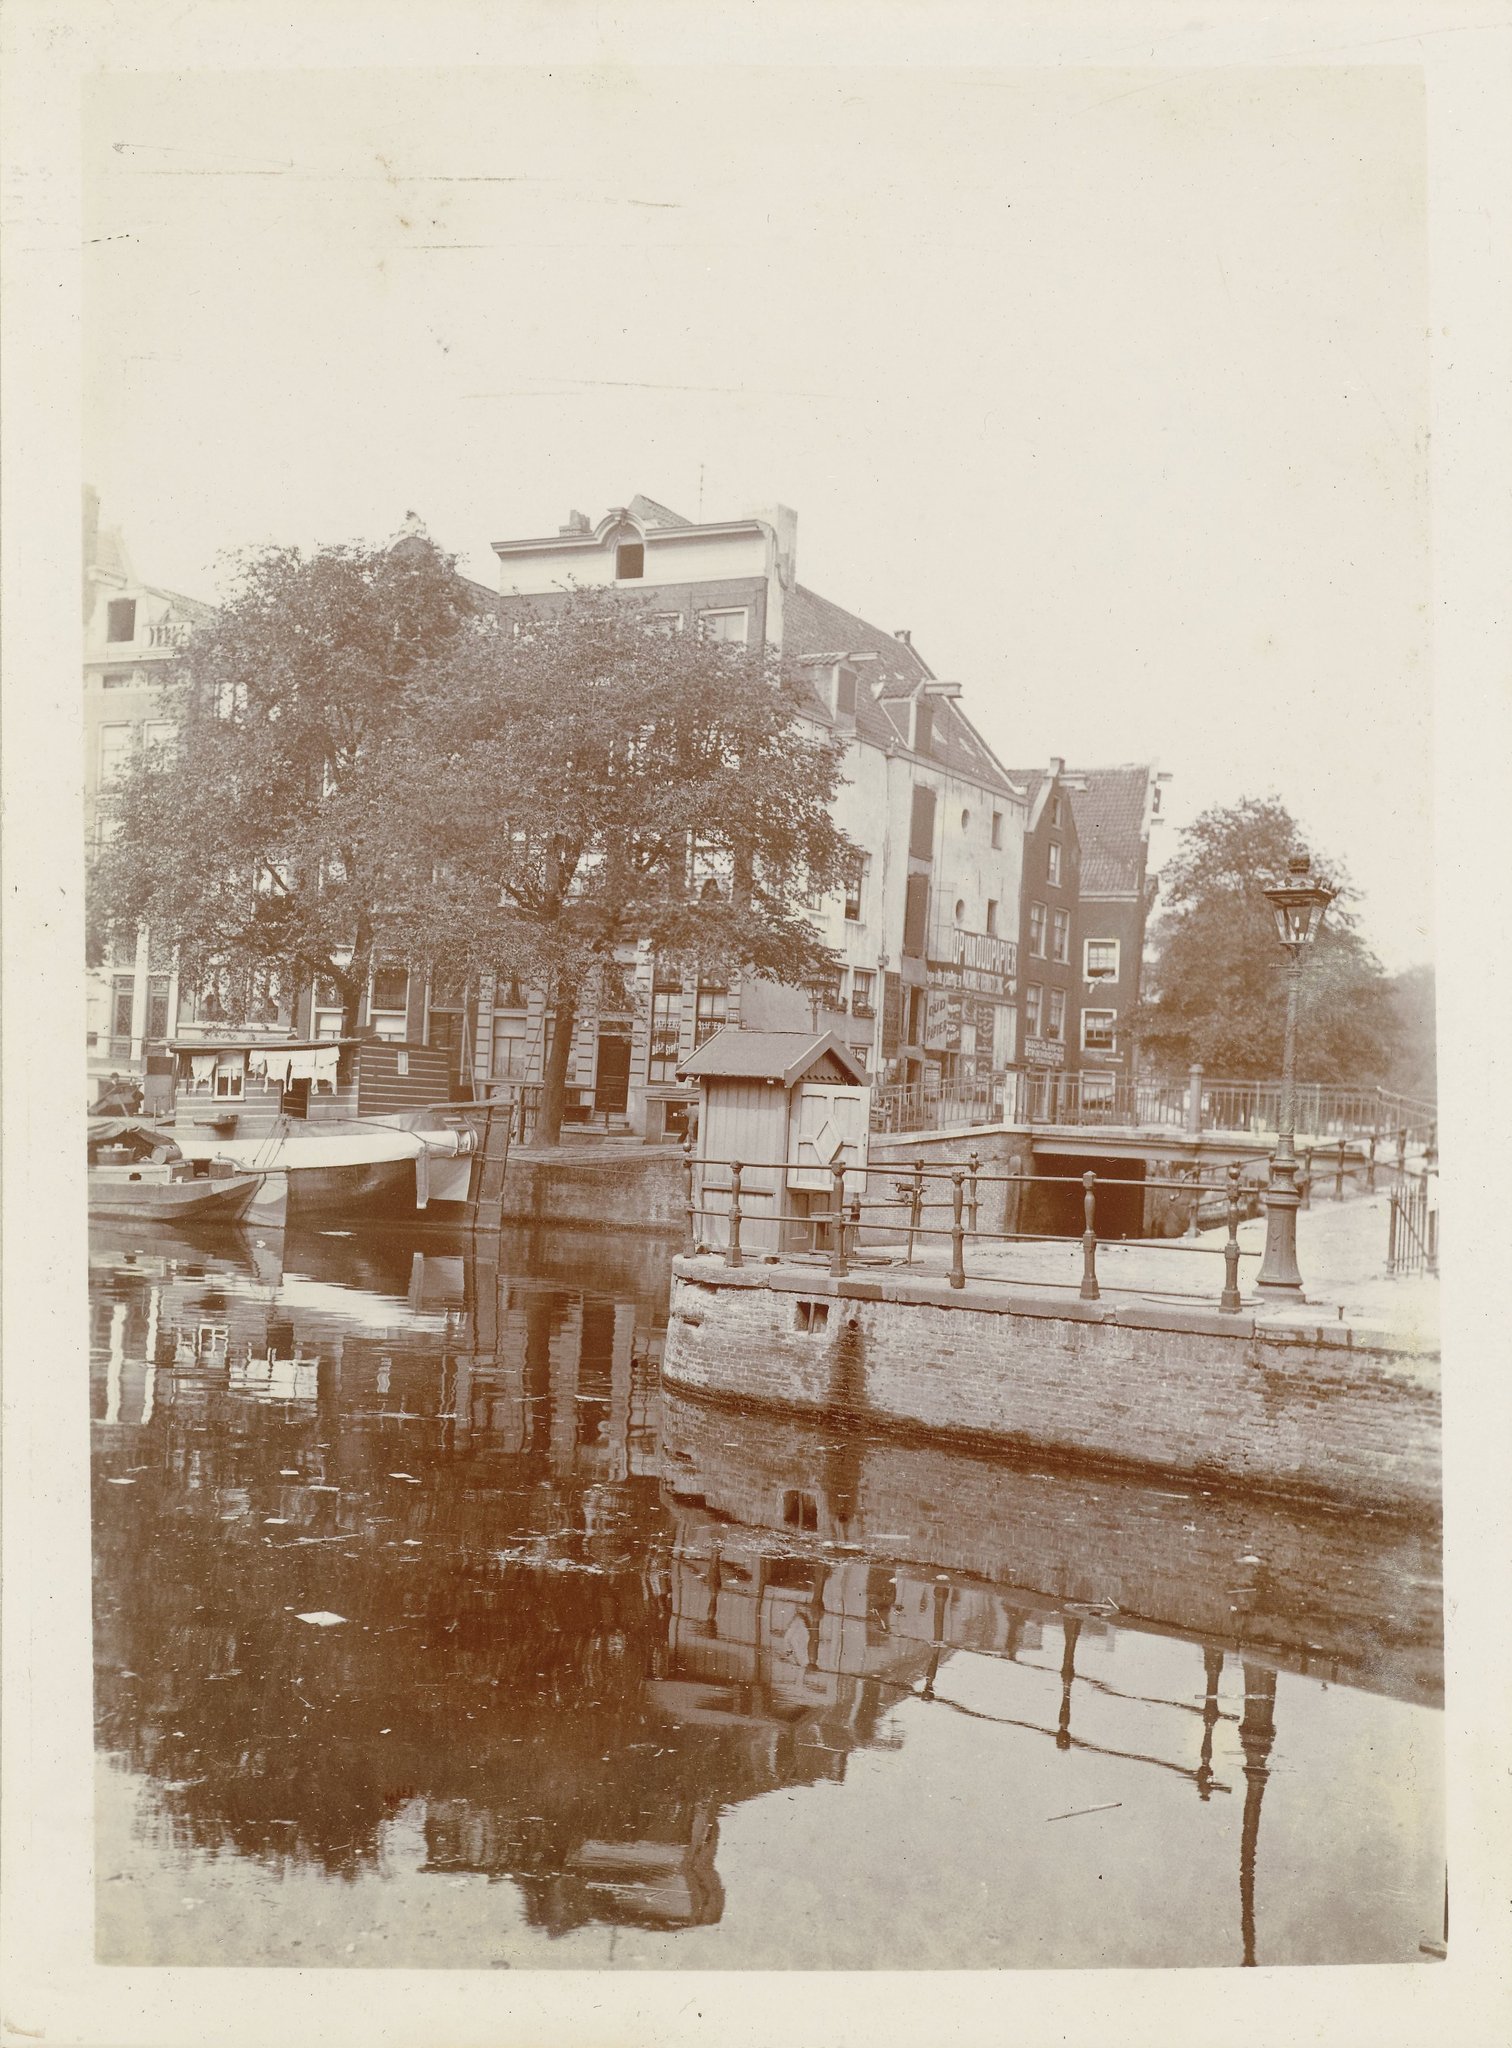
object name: photograph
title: Stadsgezicht met grachten, Amsterdam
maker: james higson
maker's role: politician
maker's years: 1862-1933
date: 1904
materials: paper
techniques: gelatin silver print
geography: amsterdam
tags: canals, waters (in city)